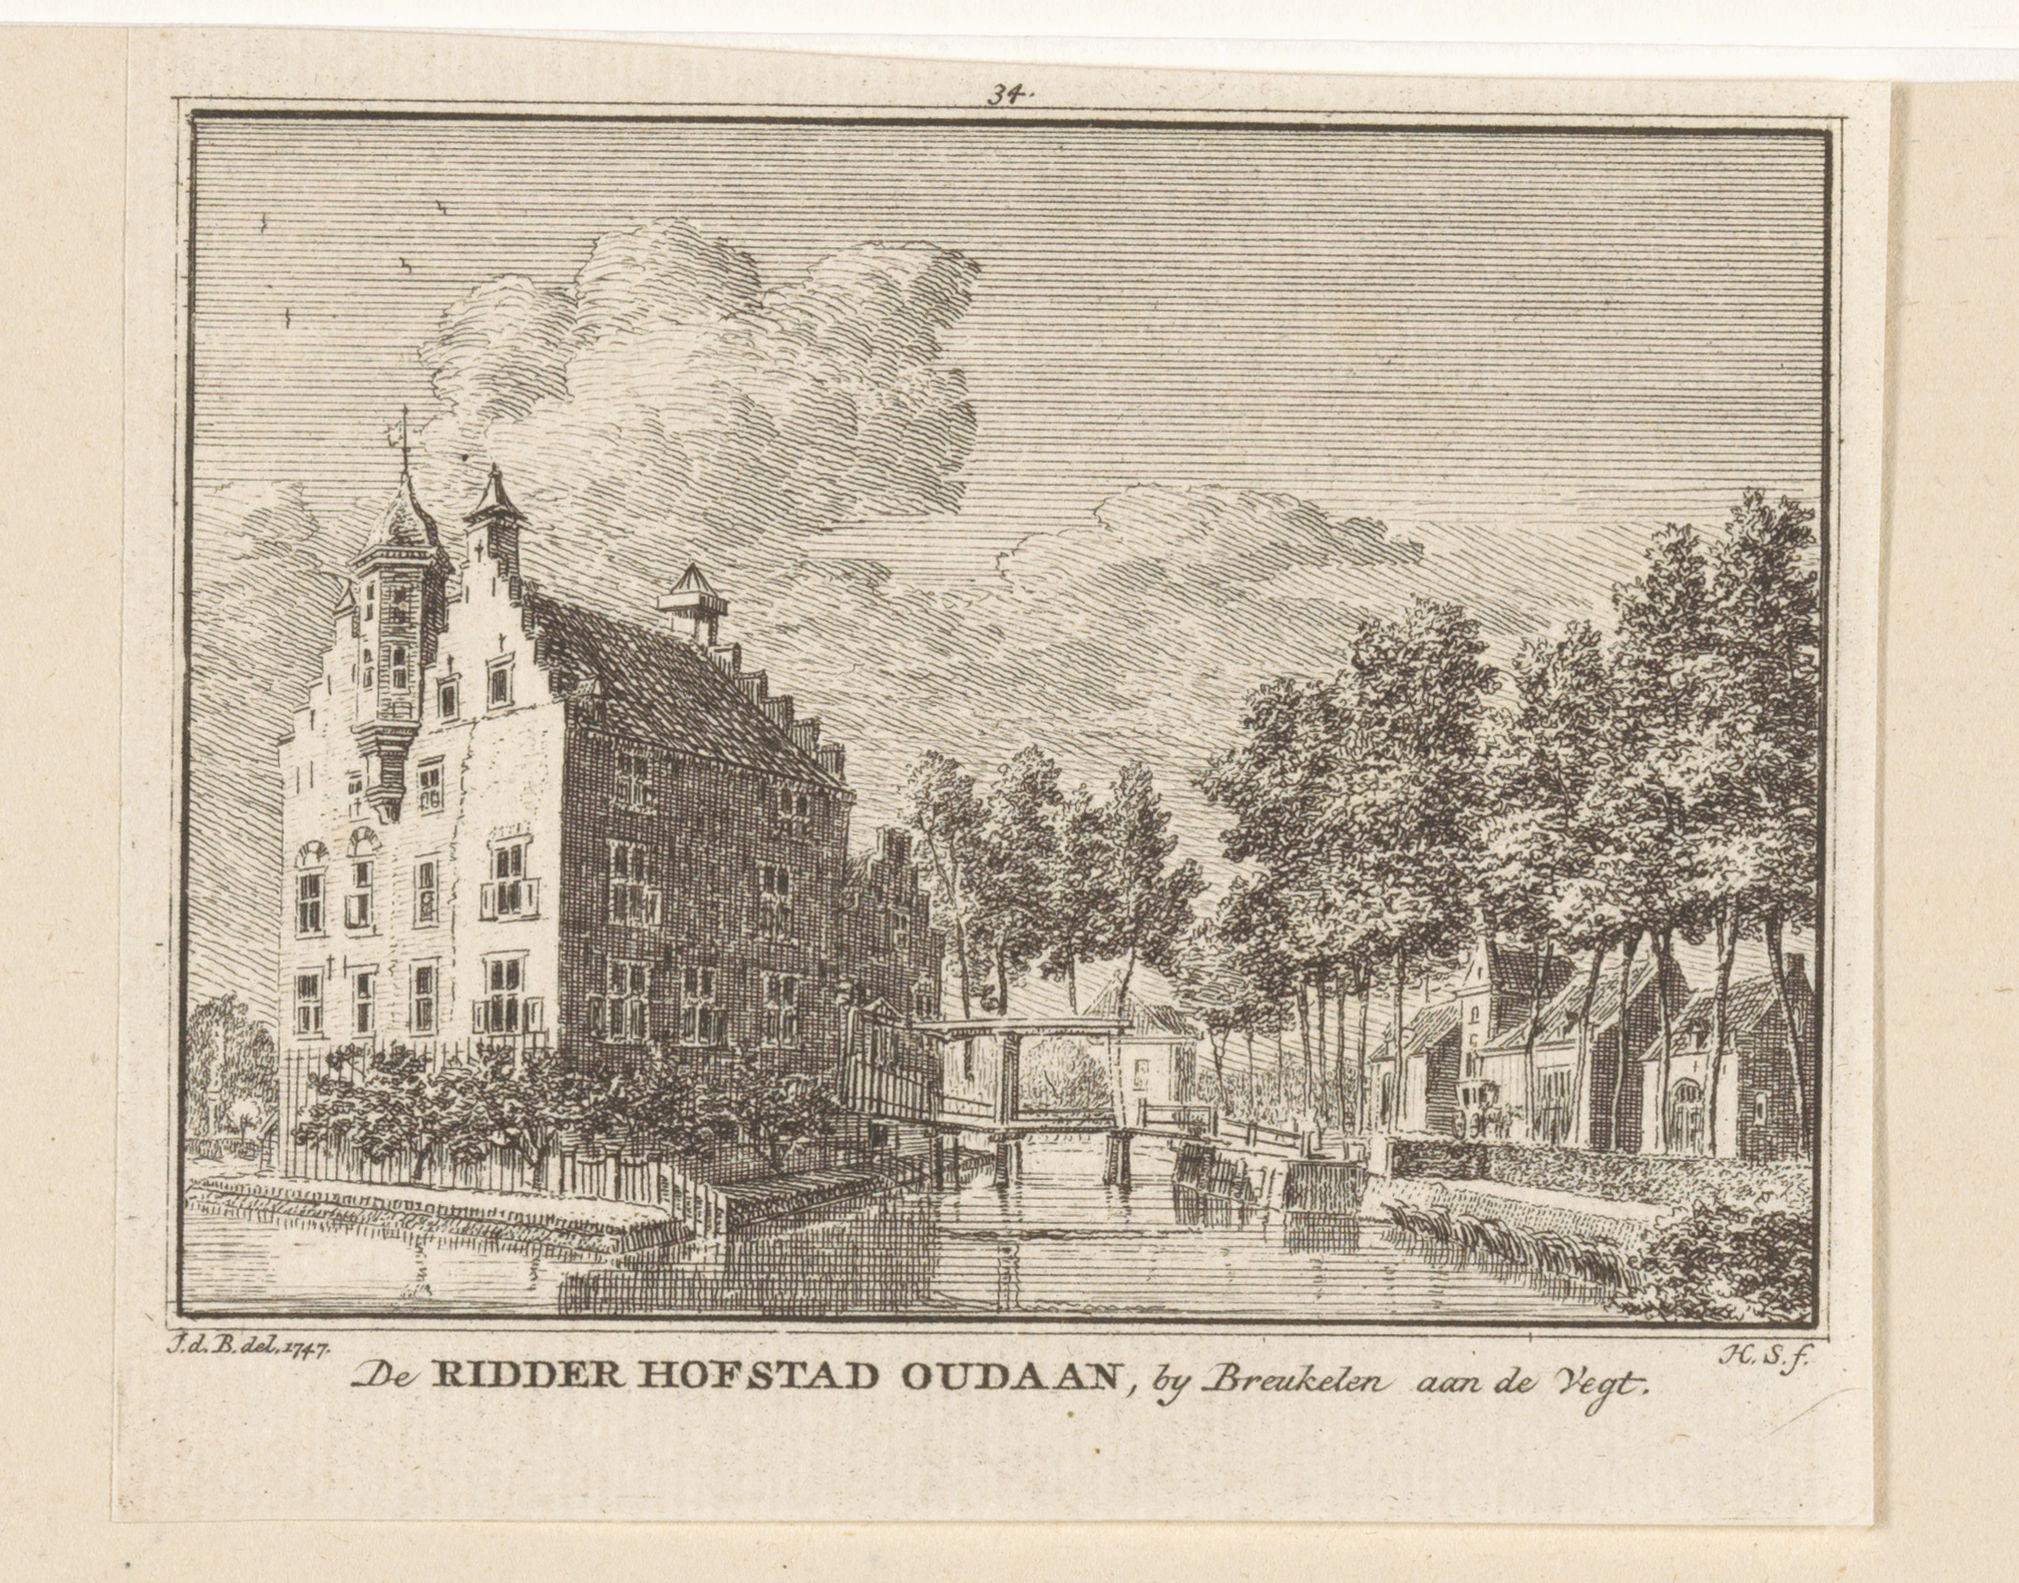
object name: print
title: Gezicht op Kasteel Oudaan te Breukelen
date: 1773-1792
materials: paper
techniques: engraving, etching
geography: haarlem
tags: castle, bridge, kasteel oudaan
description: Prent ook gebruikt in: Het verheerlykt Nederland of kabinet van hedendaagsche gezigten van steden, dorpen (…). 9 delen. Amsterdam: Isaak Tirion en weduwe Isaak Tirion, 1745-1774, dl. 7, 8 of 9 (weduwe Isaak Tirion, 1773-1774), ill. 34. Of in: Nederlandsche tafereelen; of eene keurige verzameling van negen honderd fraaije gezigten van steden, dorpen, sloten, oudheden (….). 9 delen. Amsterdam: Jan de Groot, 1792, dl. 7, 8 of 9, ill. 34. Uit welke druk het huidige exemplaar precies komt is niet na te gaan.